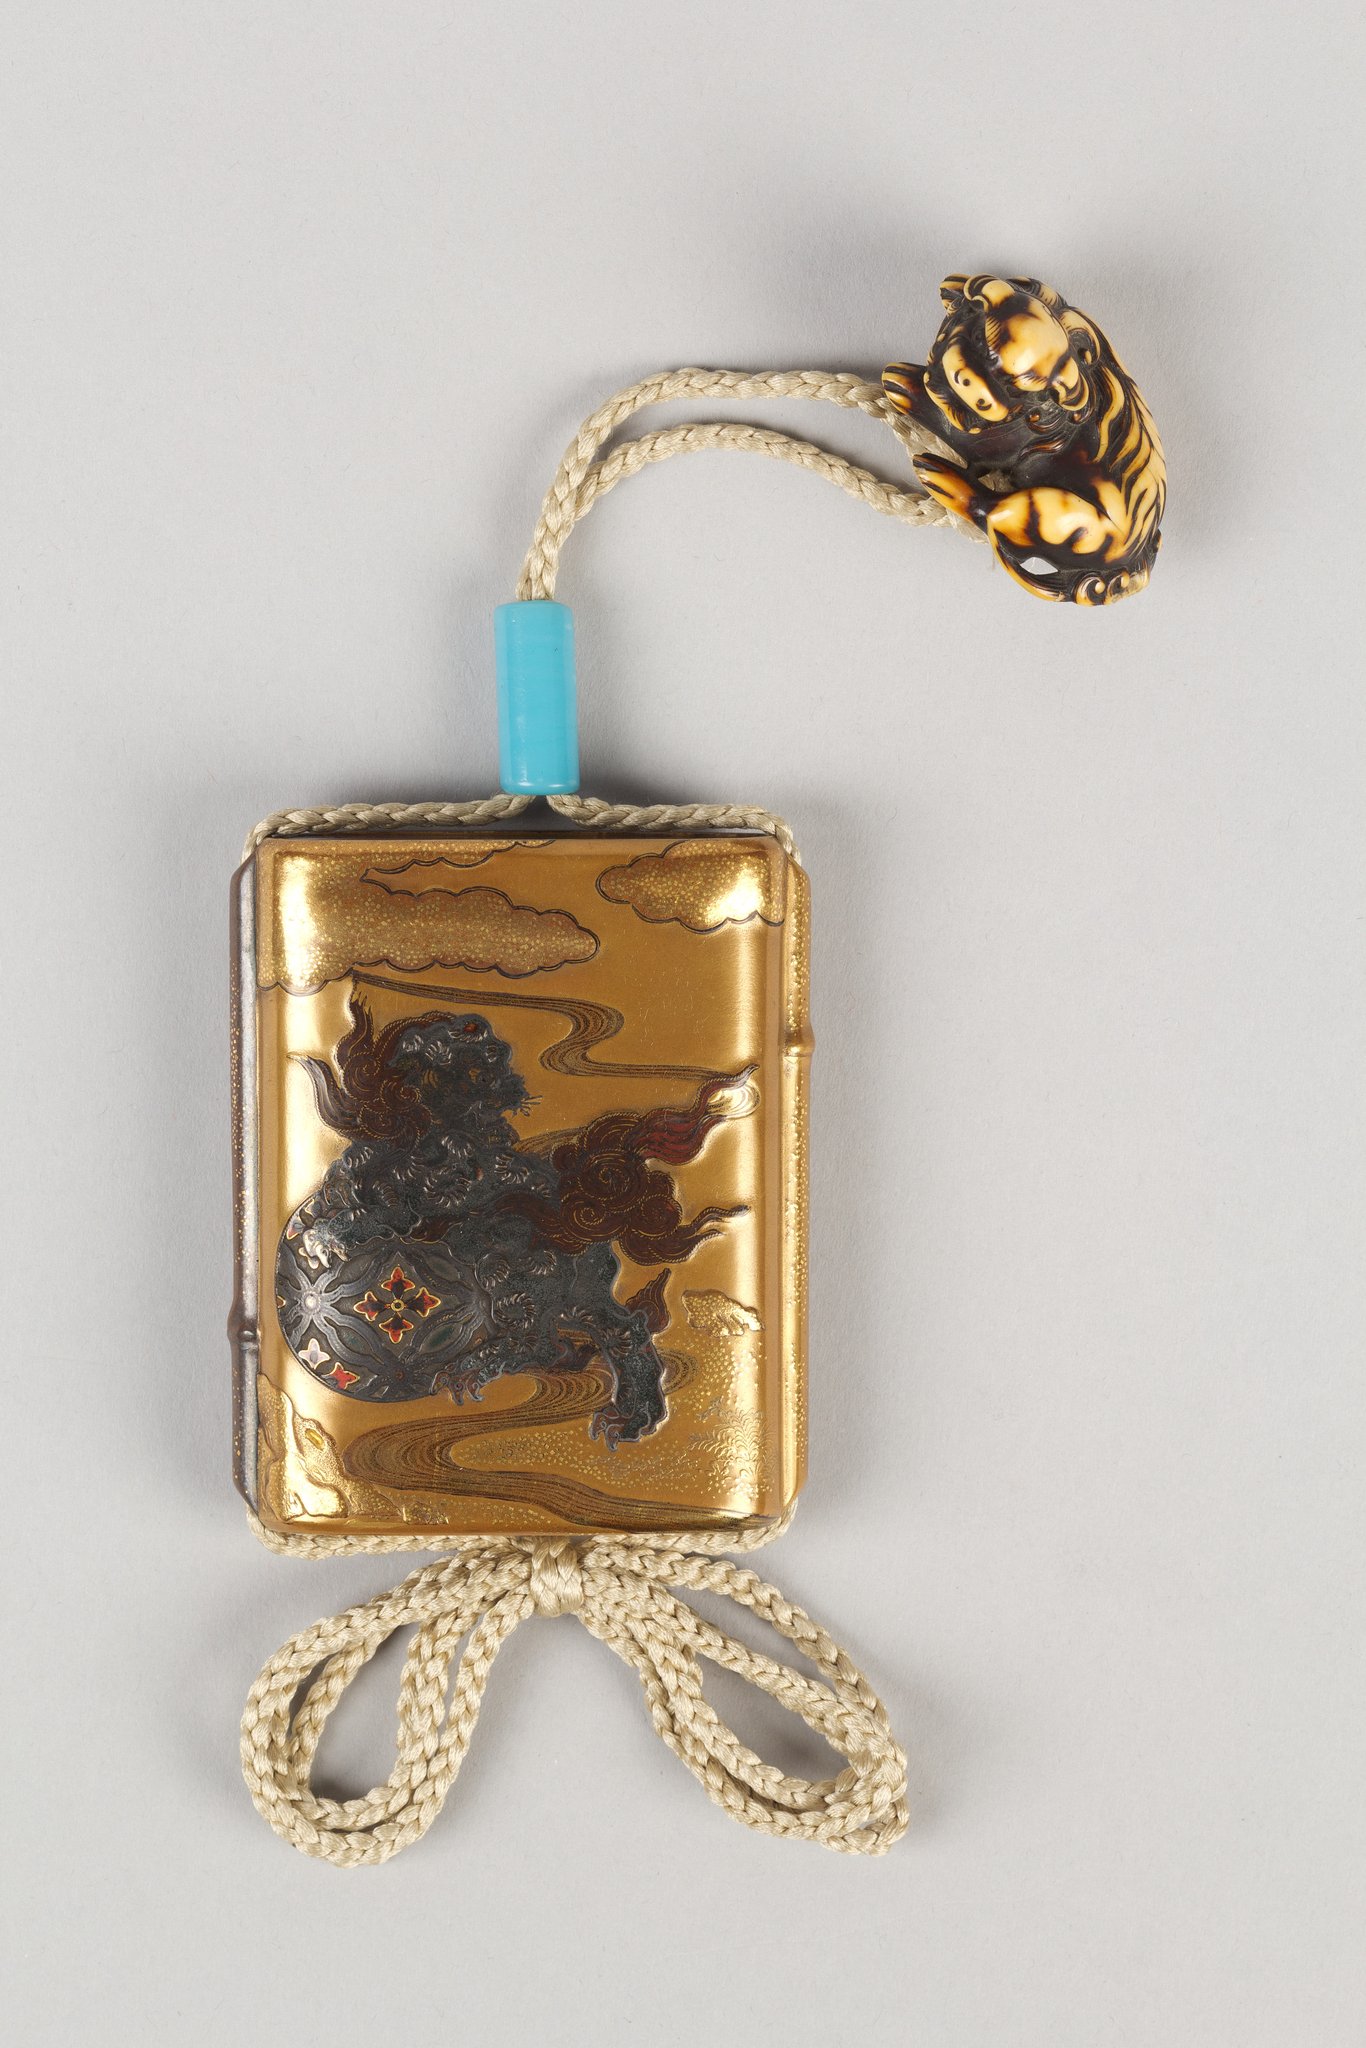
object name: inrō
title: Case (Inrō) with Design of Dog (Shishi) with Brocade Ball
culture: japanese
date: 1801-1900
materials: lacquer, metal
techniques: fundame, incising, inlay, roiro, maki-e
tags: dogs